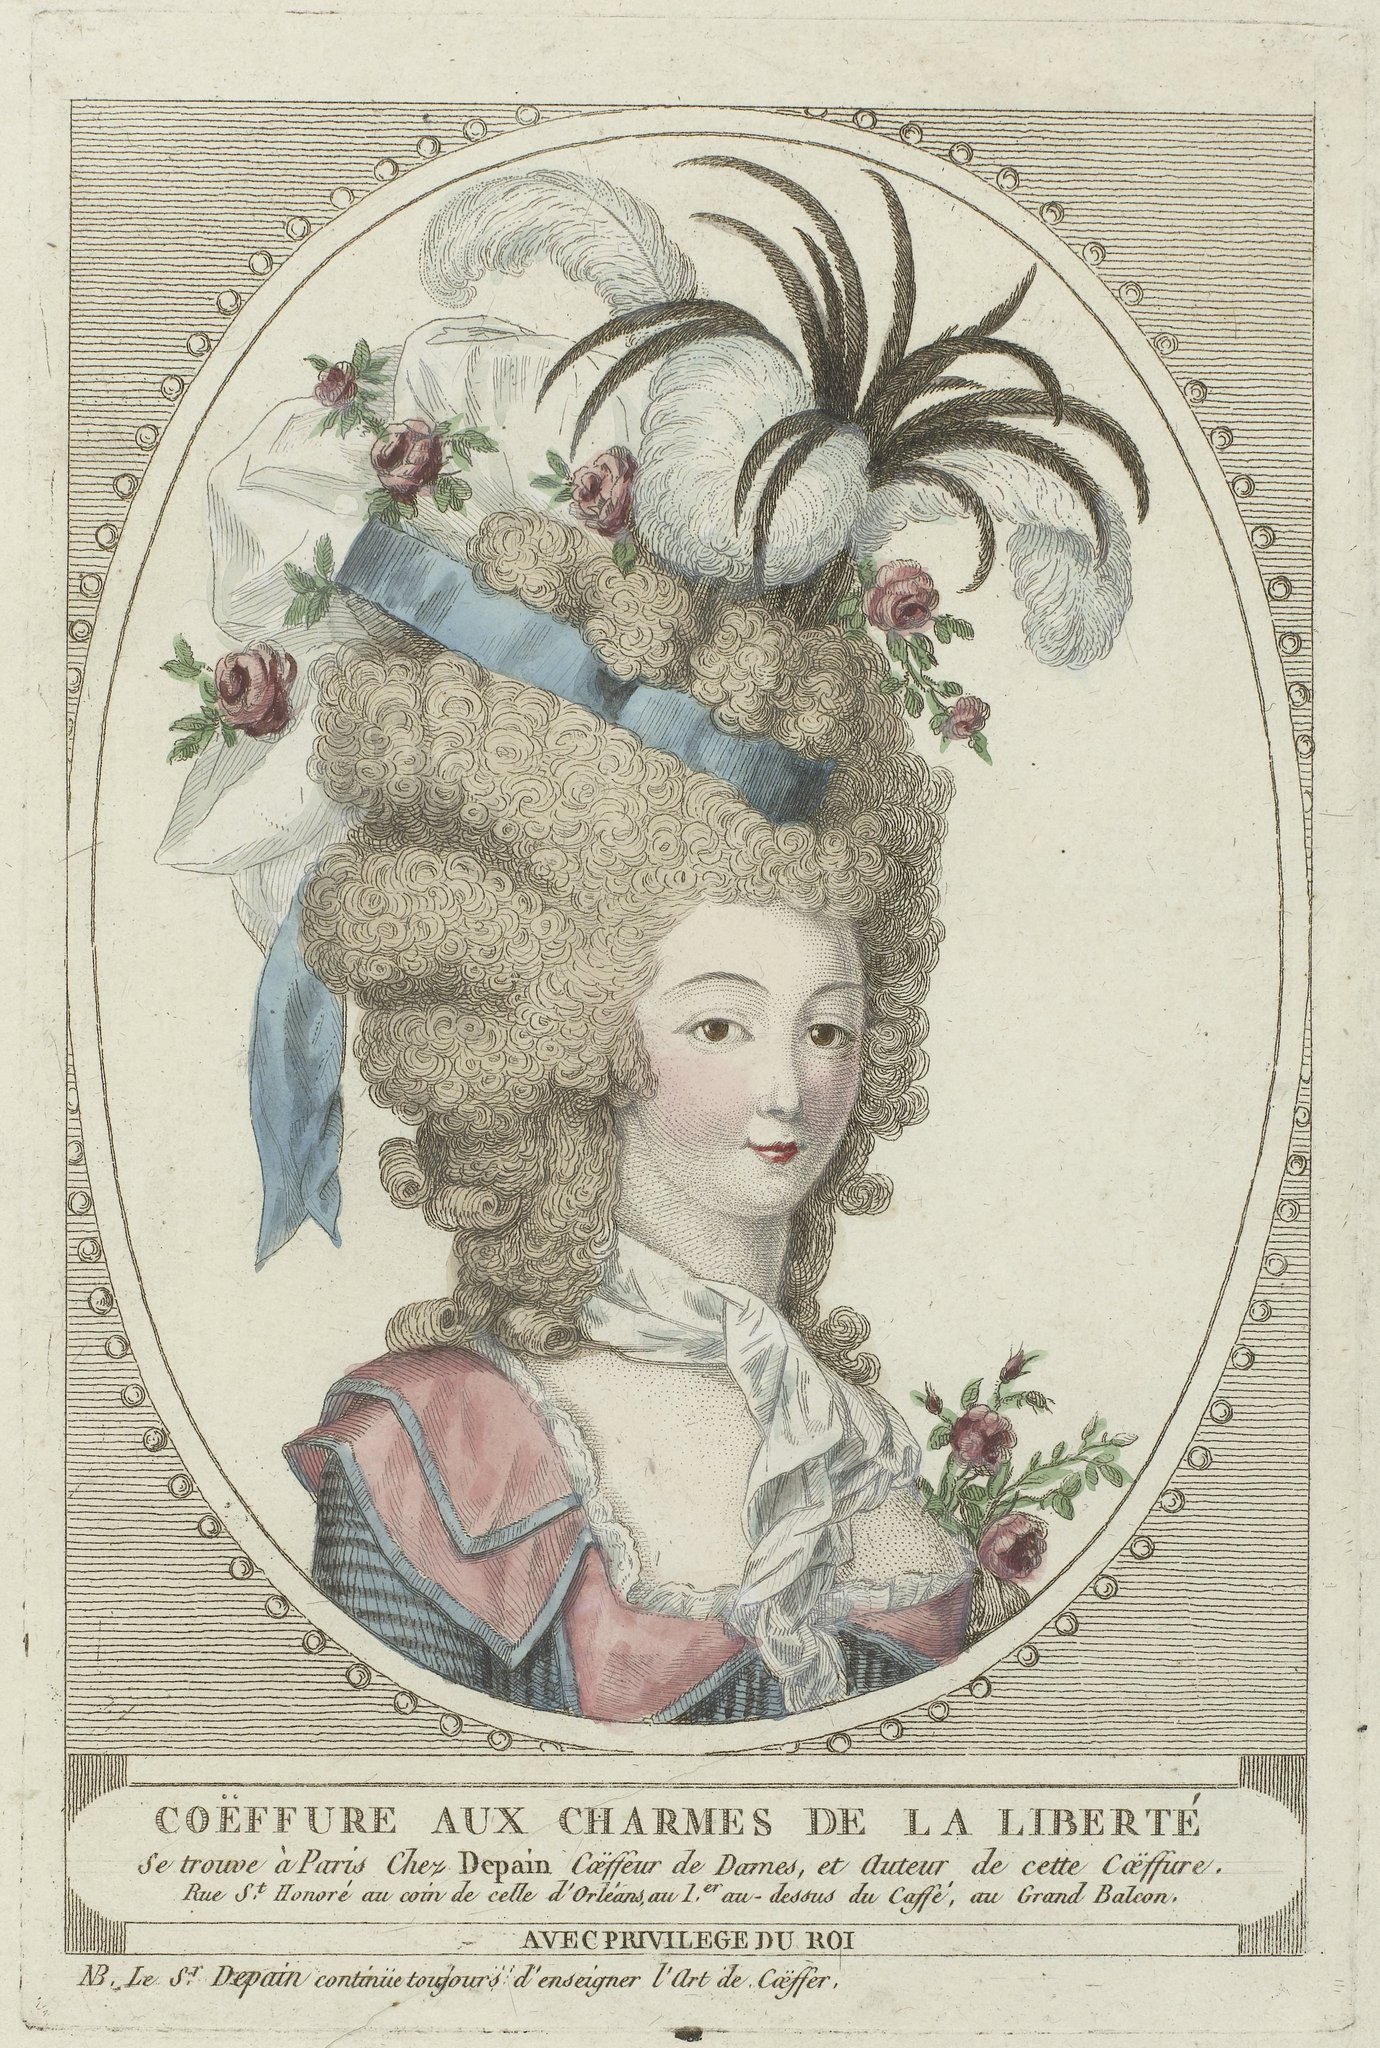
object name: fashion print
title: Coiffures, Poufs, Hats and Bonnets: Two Coiffures by the Hairdresser Depain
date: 1790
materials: paper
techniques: engraving, etching, hand coloring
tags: styles of hairdress - aa - ~ women, head-gear: cap (+ women's clothes), fashion plates, neck-gear ~ clothing (+ women's clothes)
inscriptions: caption: ‘NB. Le Sr. Depain continüe toujours d'enseigner l'Art de Coëffer.’, address: ‘Se trouvé à Paris Chez Depain Coéffeur de Dames, et Auteur de cette Coëffure. Rue St. Honoré au coin de celle d'Orleans, au 1.er au-dessus du Caffé, au Grand Balcon.’, privilege: ‘Avec Privilege du Roi.’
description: Ladies’ hairstyles were ingenious works of art, built around a core of cushions and horsehair. Hair was piled high in curls and twists (chignons) and adorned with feathers, ribbons, artificial flowers, tulle and jewels to create various fancifully named poufs. Because the hair was dressed using animal fat and powdered with wheat flour, these poufs attracted all manner of insects. Far from hygienic, they moreover did not last long. When they went out, ladies protected their hairdos with a voluminous ribbed hood called a calèche 1. Hairdressers of the time, who styled themselves as artists, used prints to advertise their latest creations and craftsmanship 2 3.